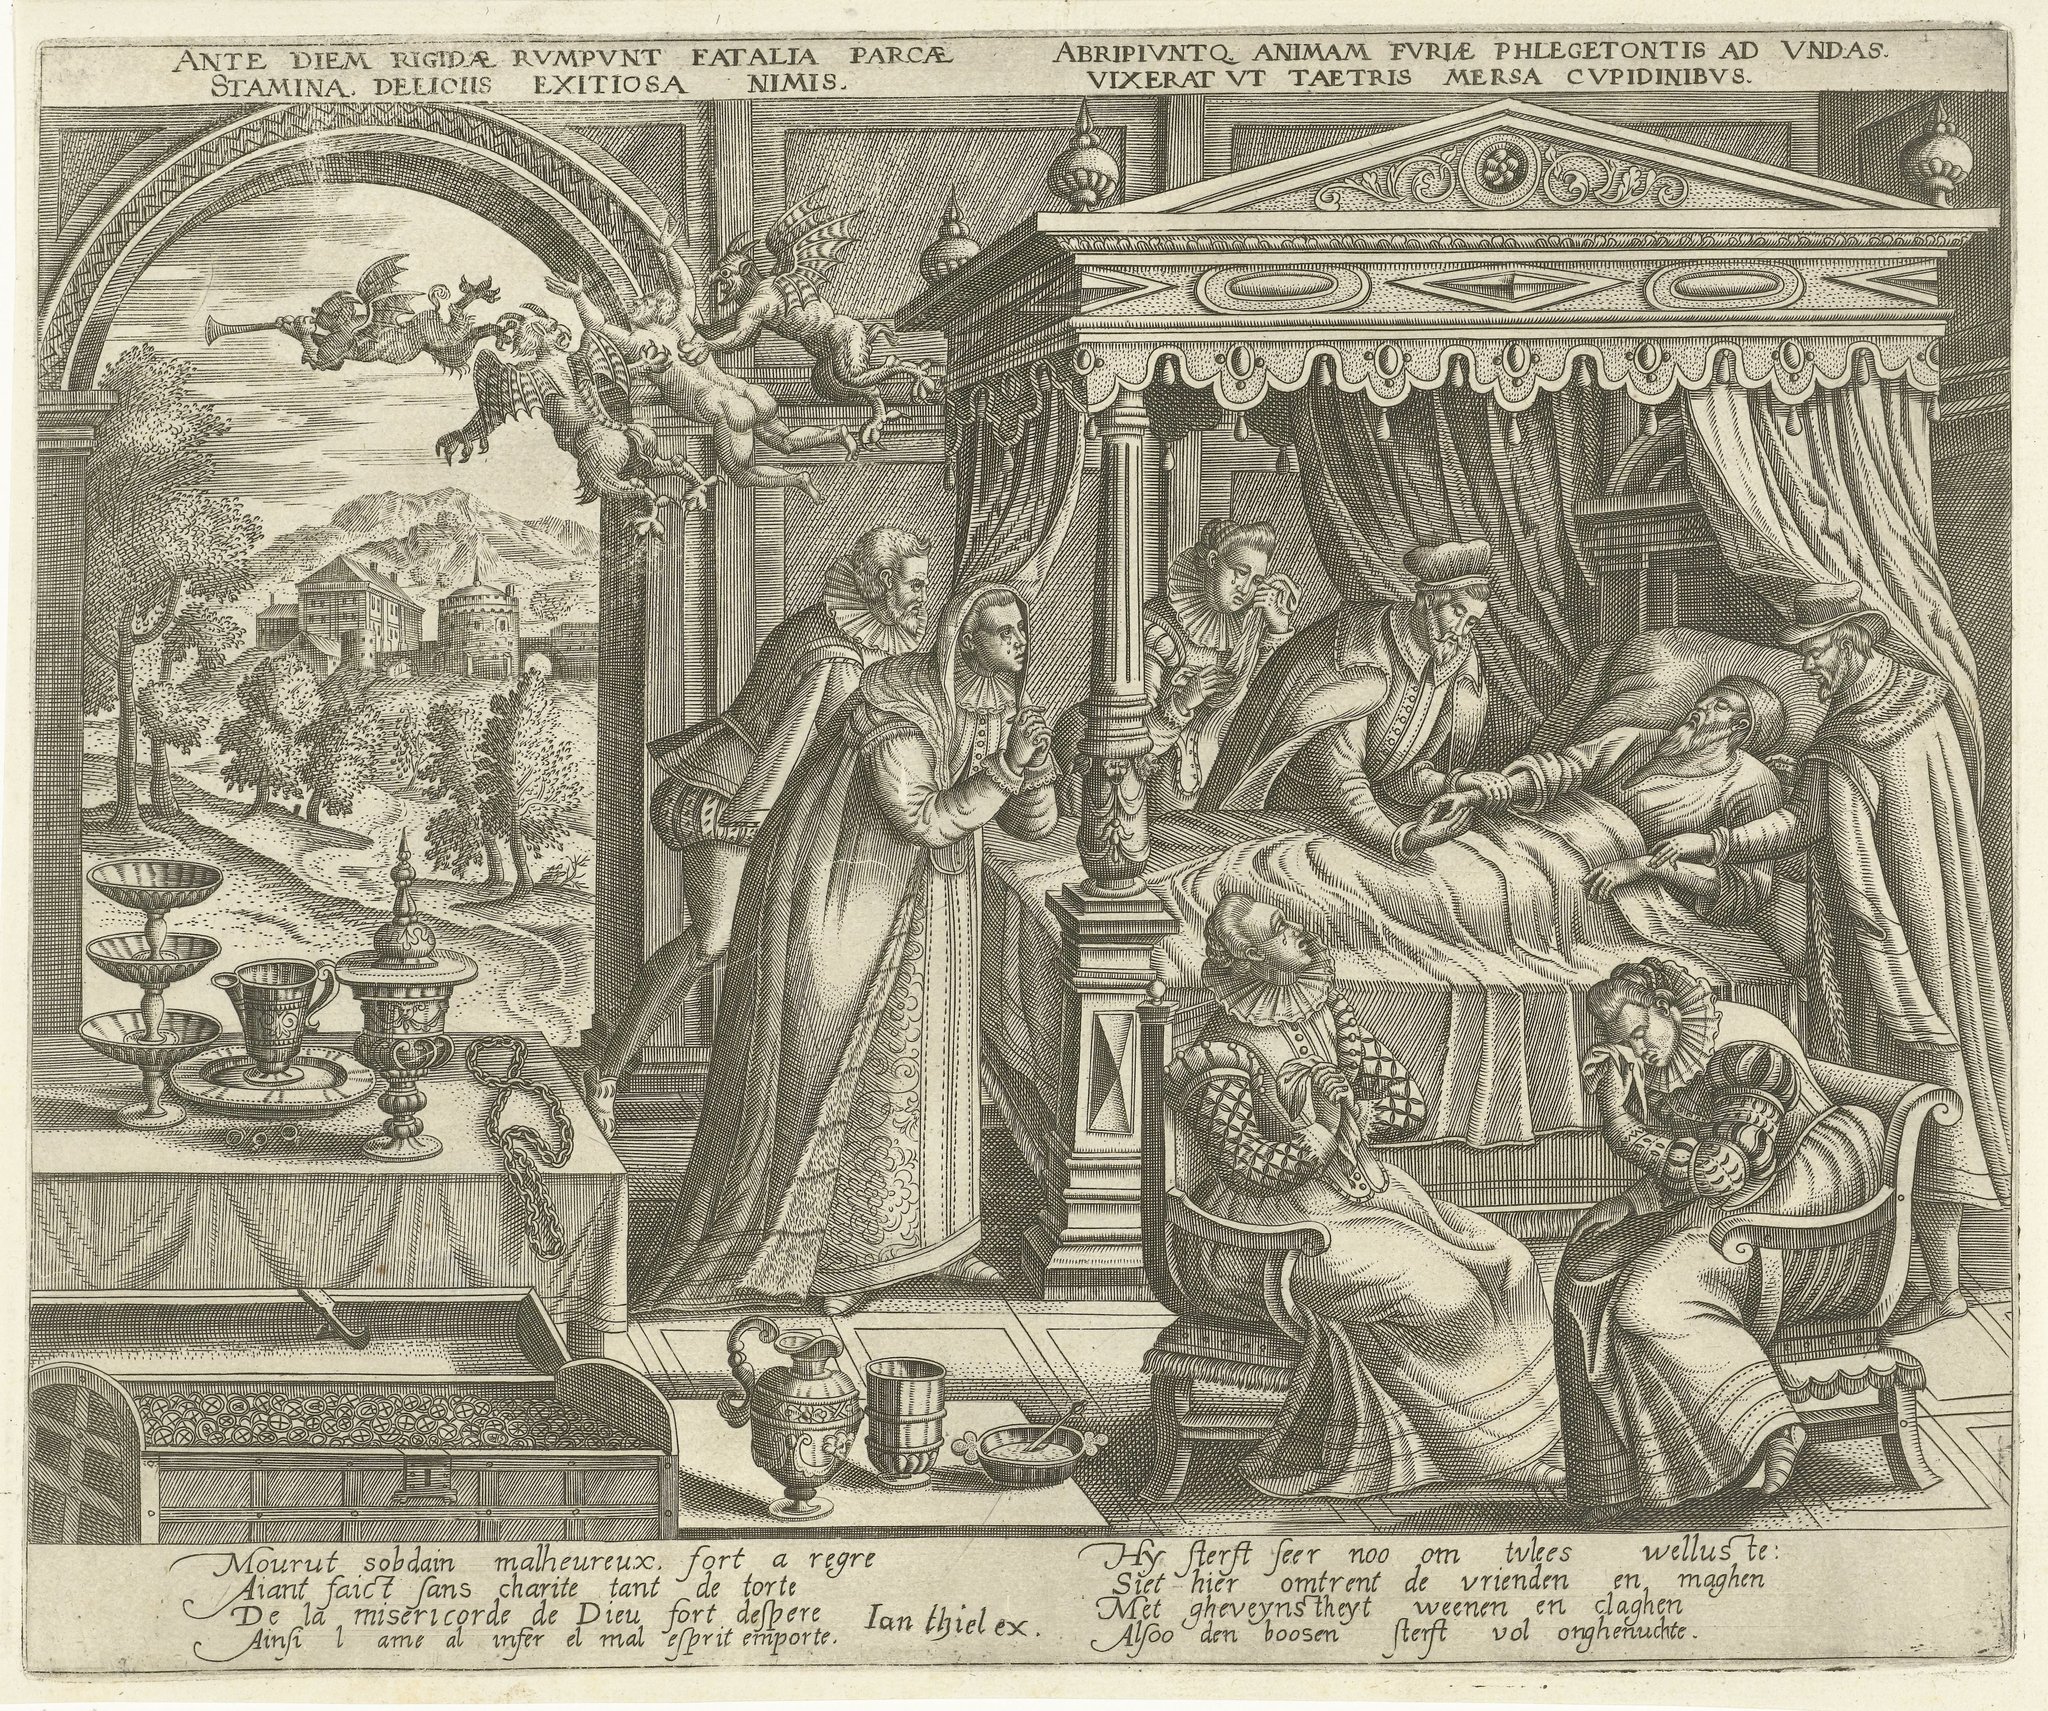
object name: print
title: Gelijkenis van de rijke man en de arme Lazarus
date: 1575-1599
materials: paper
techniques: engraving, etching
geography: amsterdam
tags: bed with tester, dives dies; his soul is brought into hell by devils, deathbed, devil(s) and demons, clothes, costume (+ women's clothes), clothes, costume (+ men's clothes), mourning the dead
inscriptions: collector's mark: Lugt 2228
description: De rijke man ligt in een hemelbed, omgeven door doktoren en wenende vrouwen. Links op een tafel vaatwerk en sieraden. Door de deuropening vliegen kleine duivels die de rijke man door de lucht meevoeren. Linksvoor een open geldkist. De prent heeft een Latijns opschrift en een Nederlands en Frans onderschrift. Hij maakt deel uit van een serie over gelijkenis van de rijke man en Lazarus.